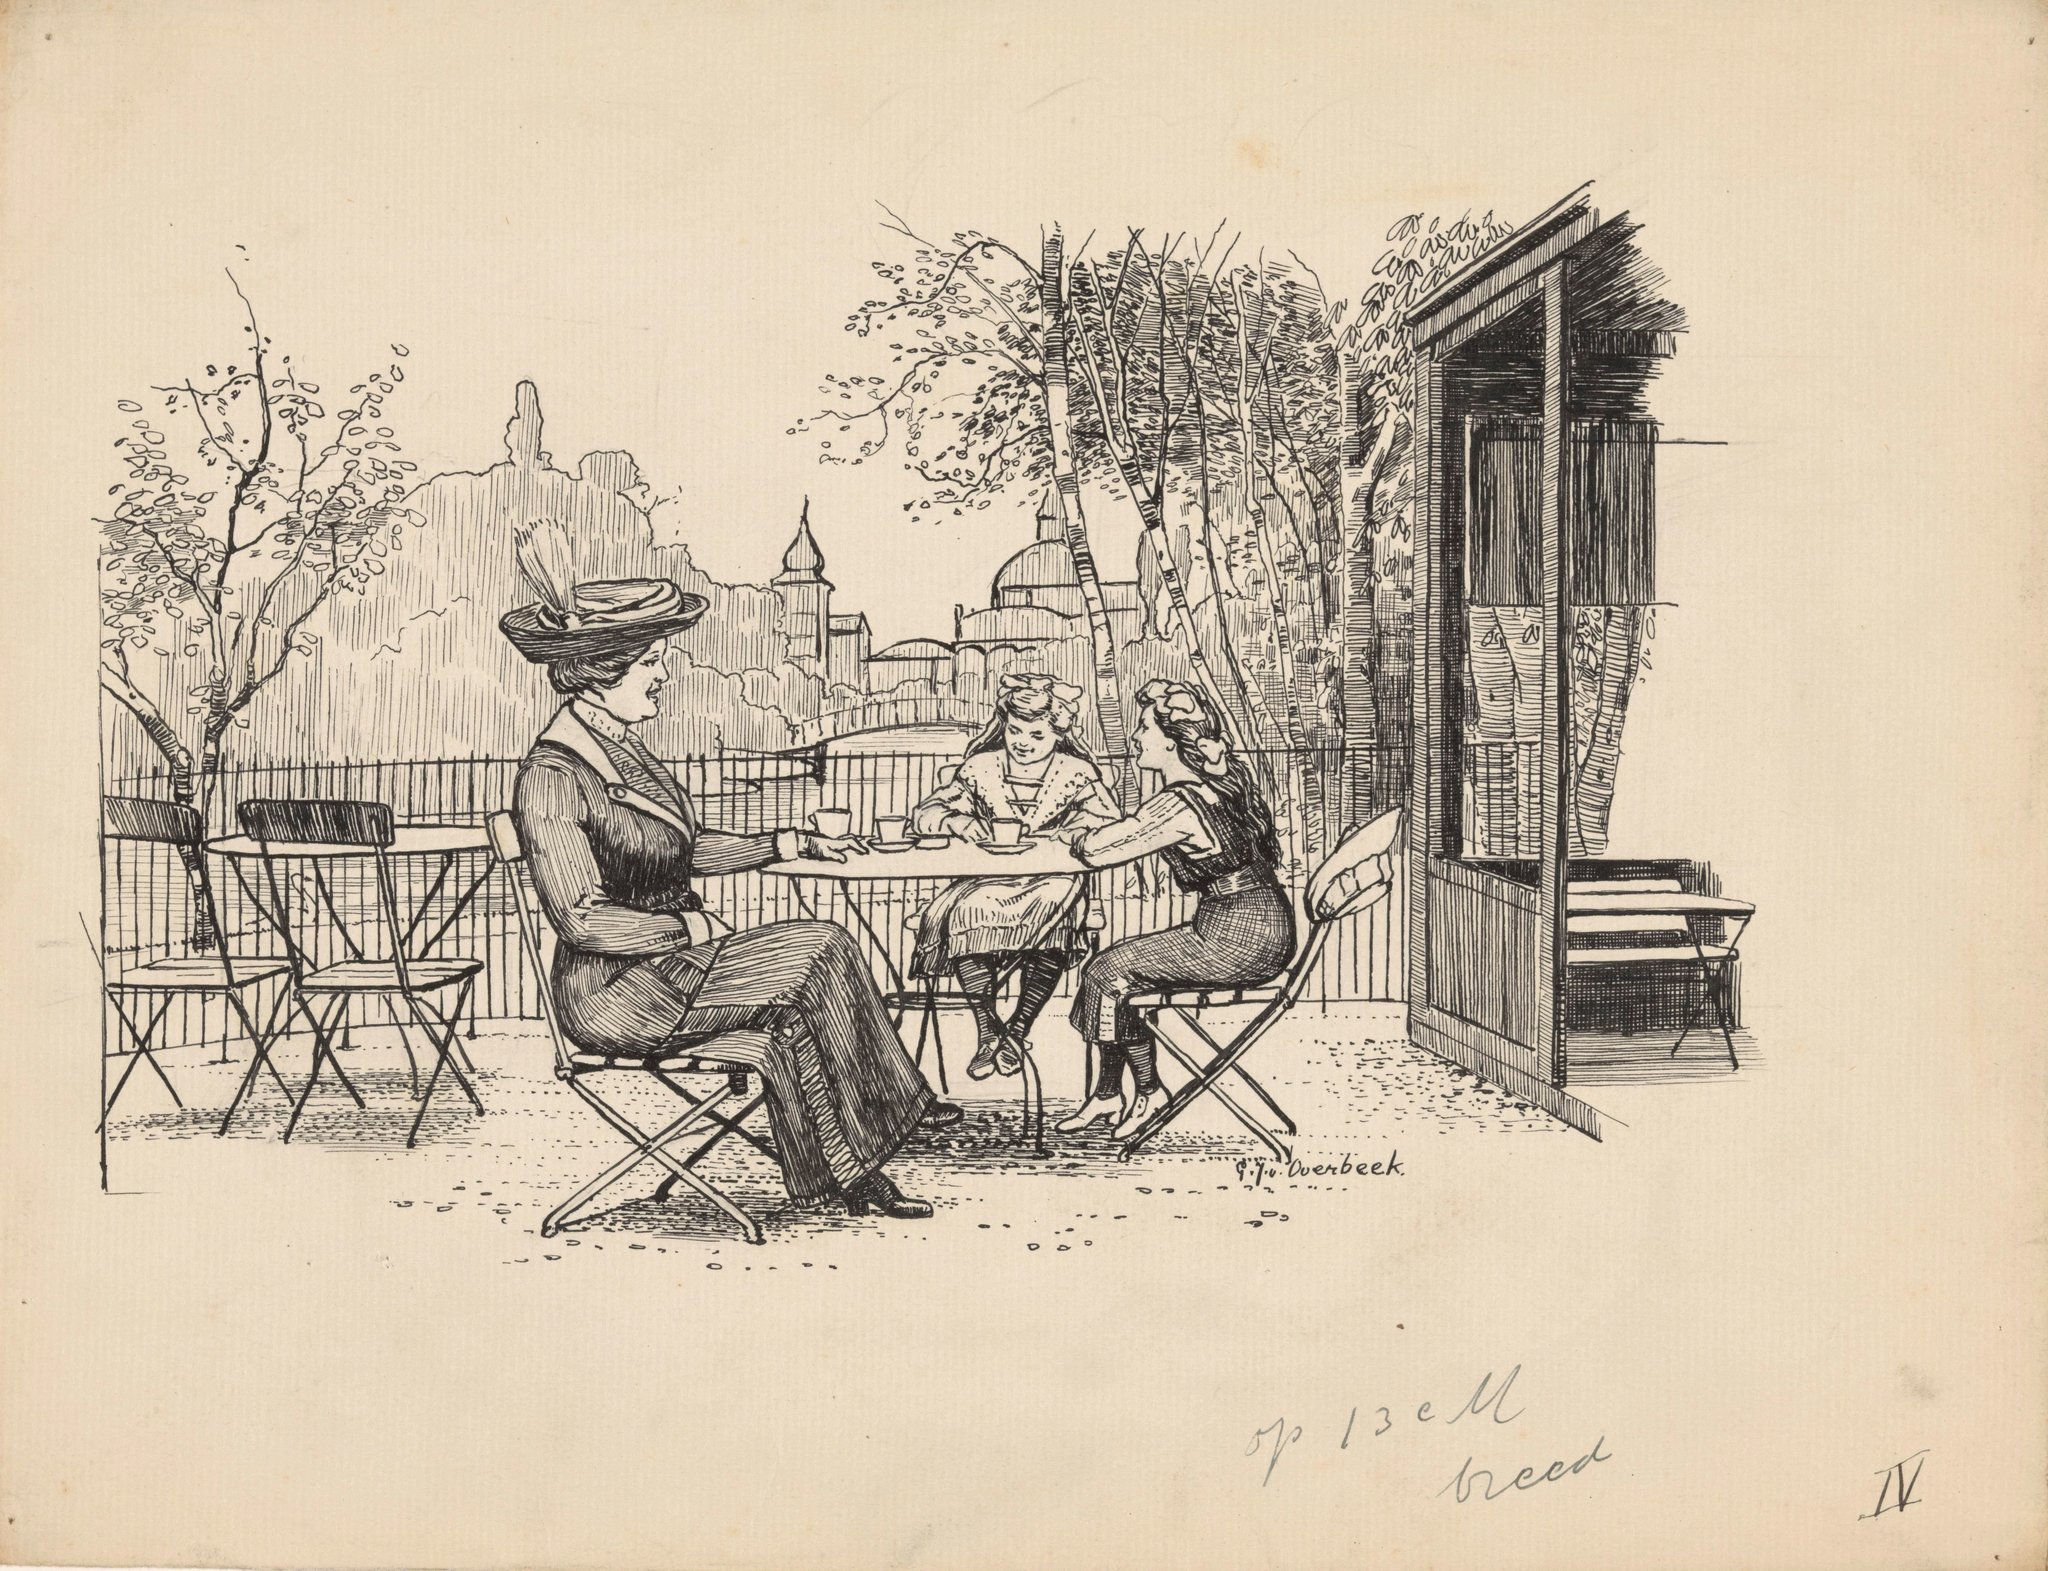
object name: drawing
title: Vrouw en twee meisjes op een terras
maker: gijsbertus johannes van overbeek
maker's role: draughtsman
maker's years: 1882-1947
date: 1892-1947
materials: ink, paper, pencil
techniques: pen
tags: river, pavement, terrace in front of inn or restaurant, bridge, cup of tea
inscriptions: collector's mark: Lugt 2228, :, number: ‘IV’, signature: ‘G.J. v. Overbeek.’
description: Op een terras drinken twee meisjes en een vrouw een kop thee of koffie. In de achtergrond een brug over een rivier en de silhouetten van twee torens.